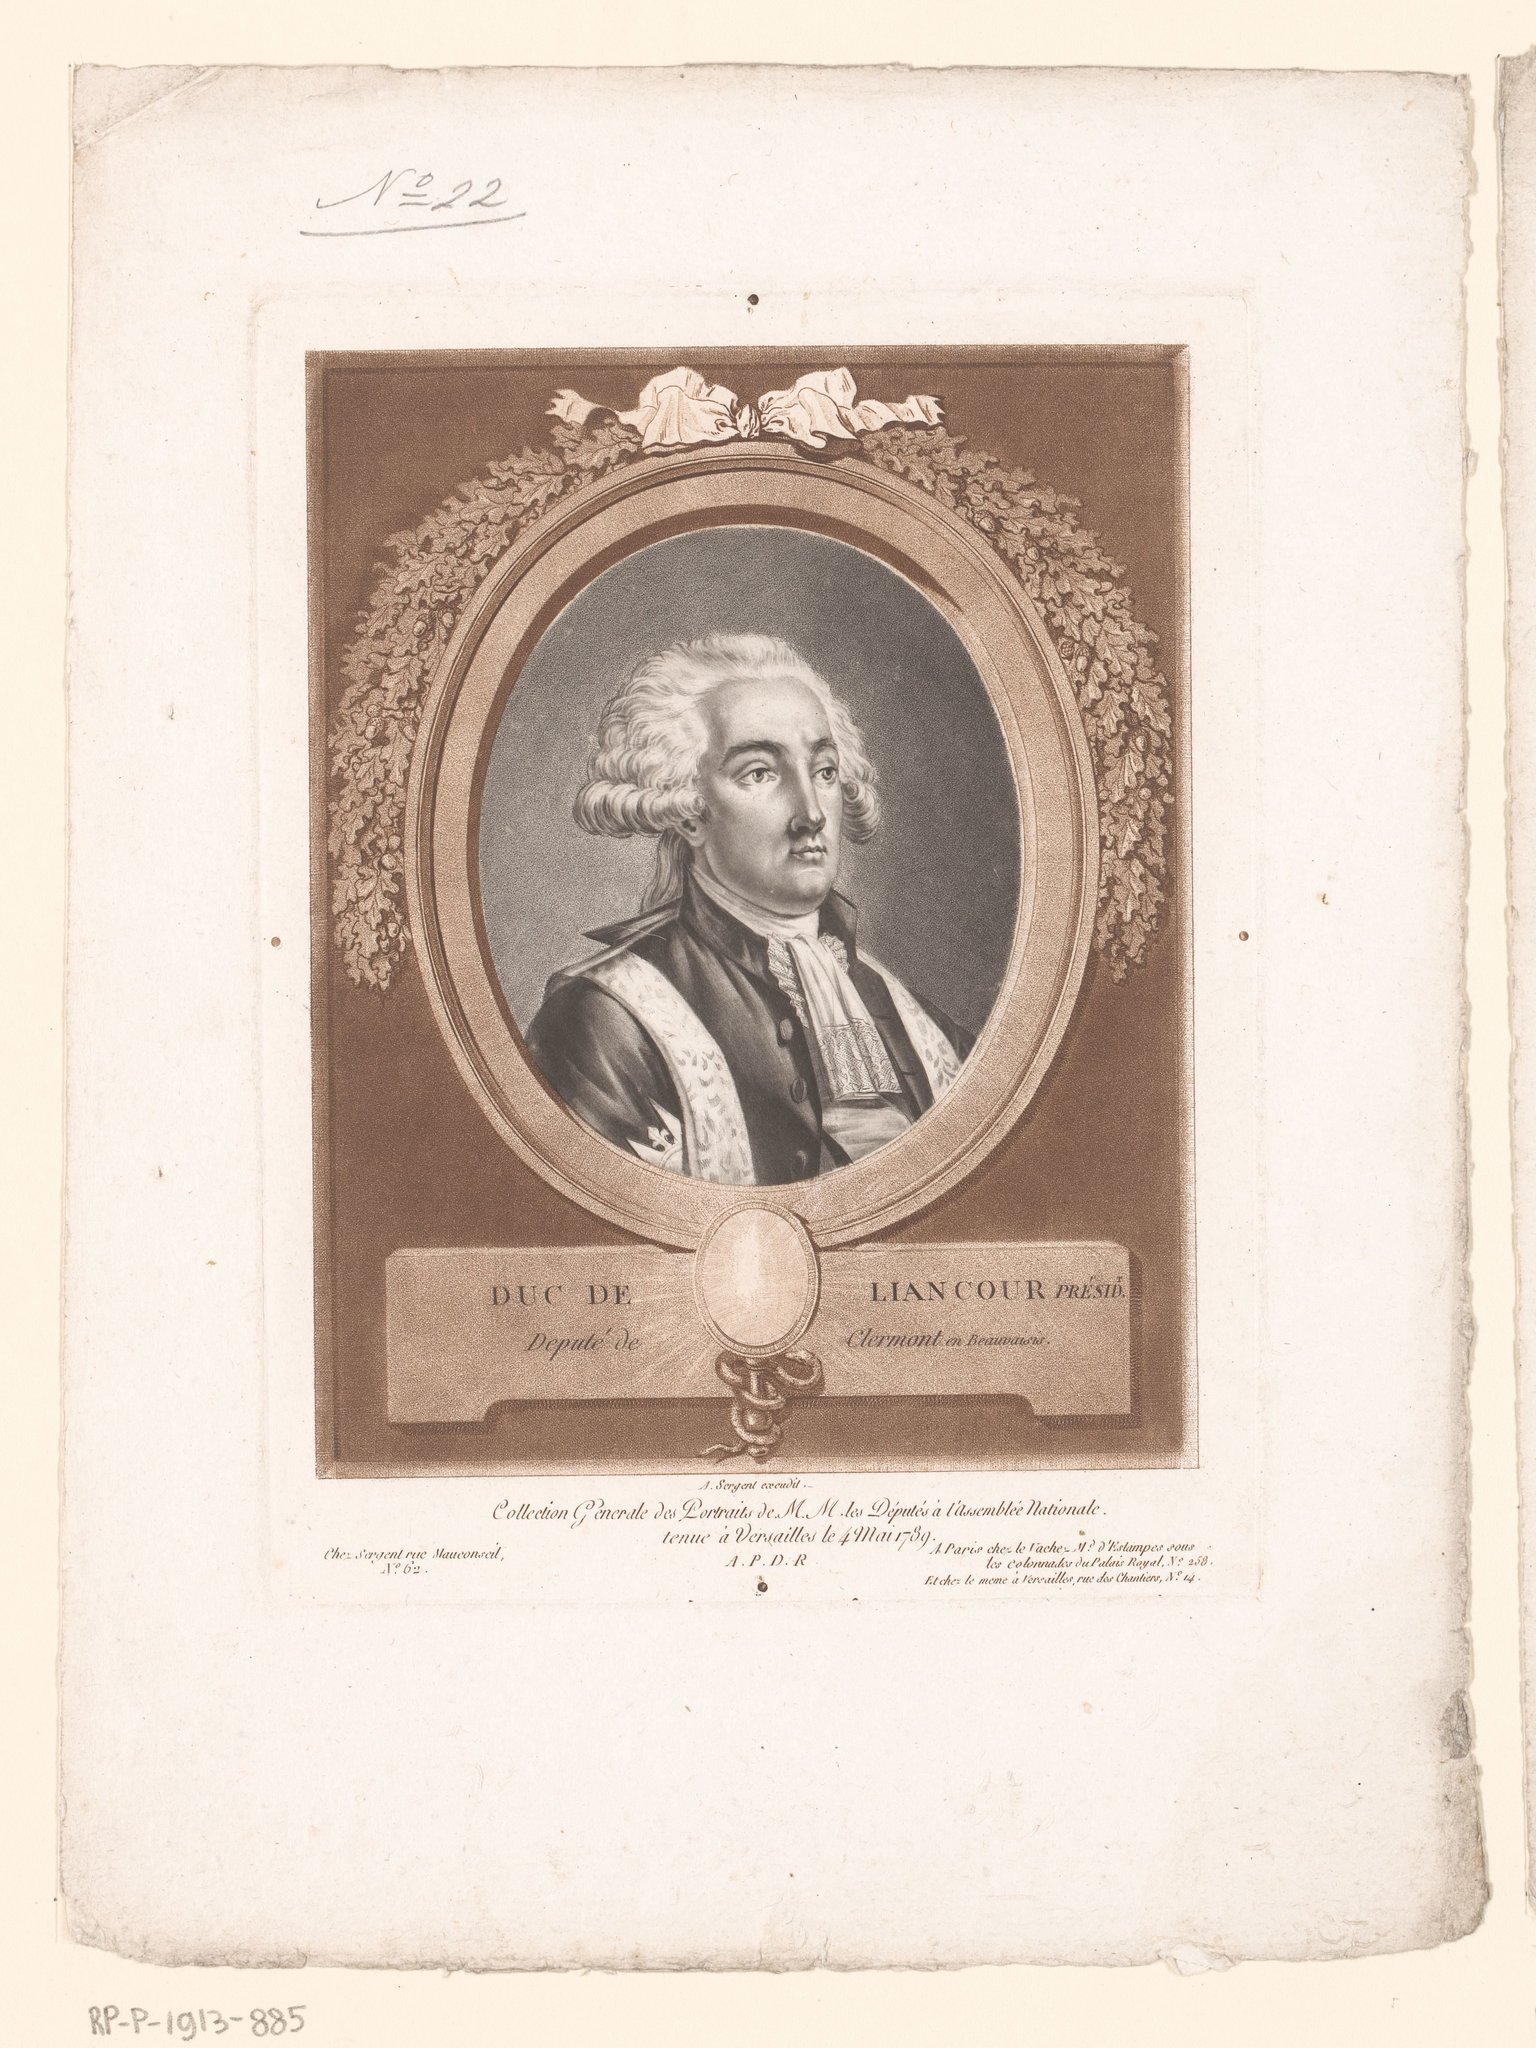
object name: print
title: Portret van François XII Alexandre Frédéric, hertog van La Rochefoucauld-Liancourt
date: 1789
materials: paper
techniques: aquatint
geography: paris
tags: paris, politician, historical persons, politician, e.g. party leader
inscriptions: collector's mark: Lugt 2228